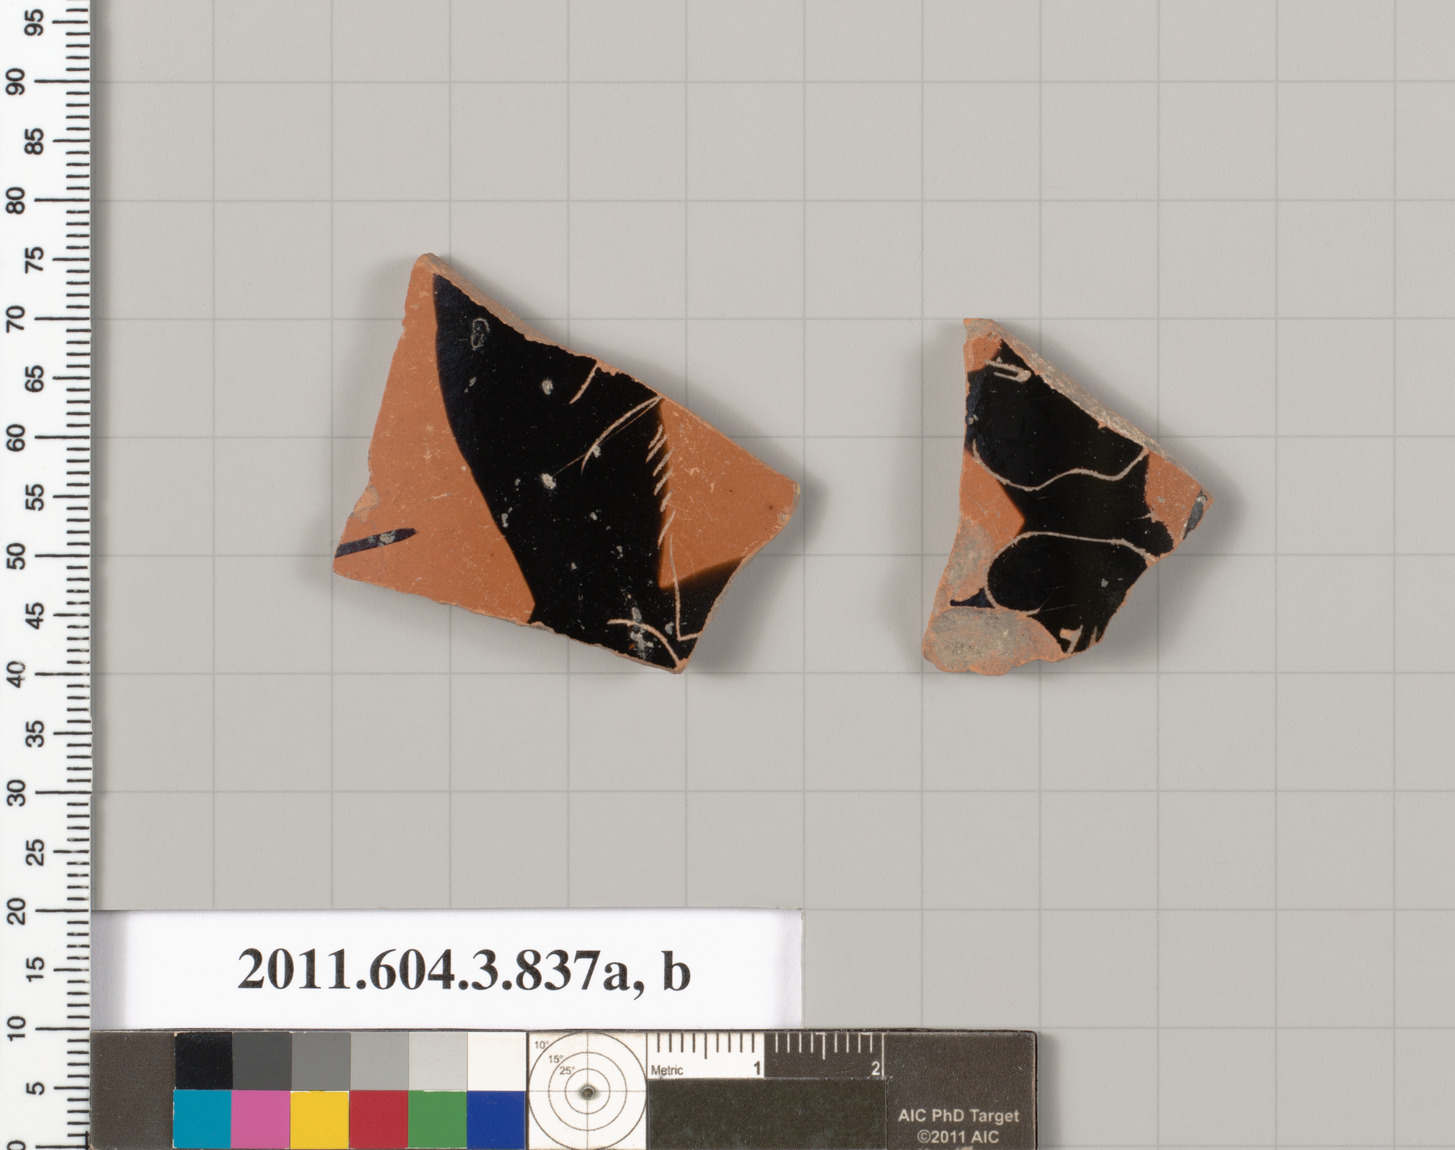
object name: lekythos fragment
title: Terracotta fragments of a lekythos (oil flask)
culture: greek, attic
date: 534-468 BCE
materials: terracotta